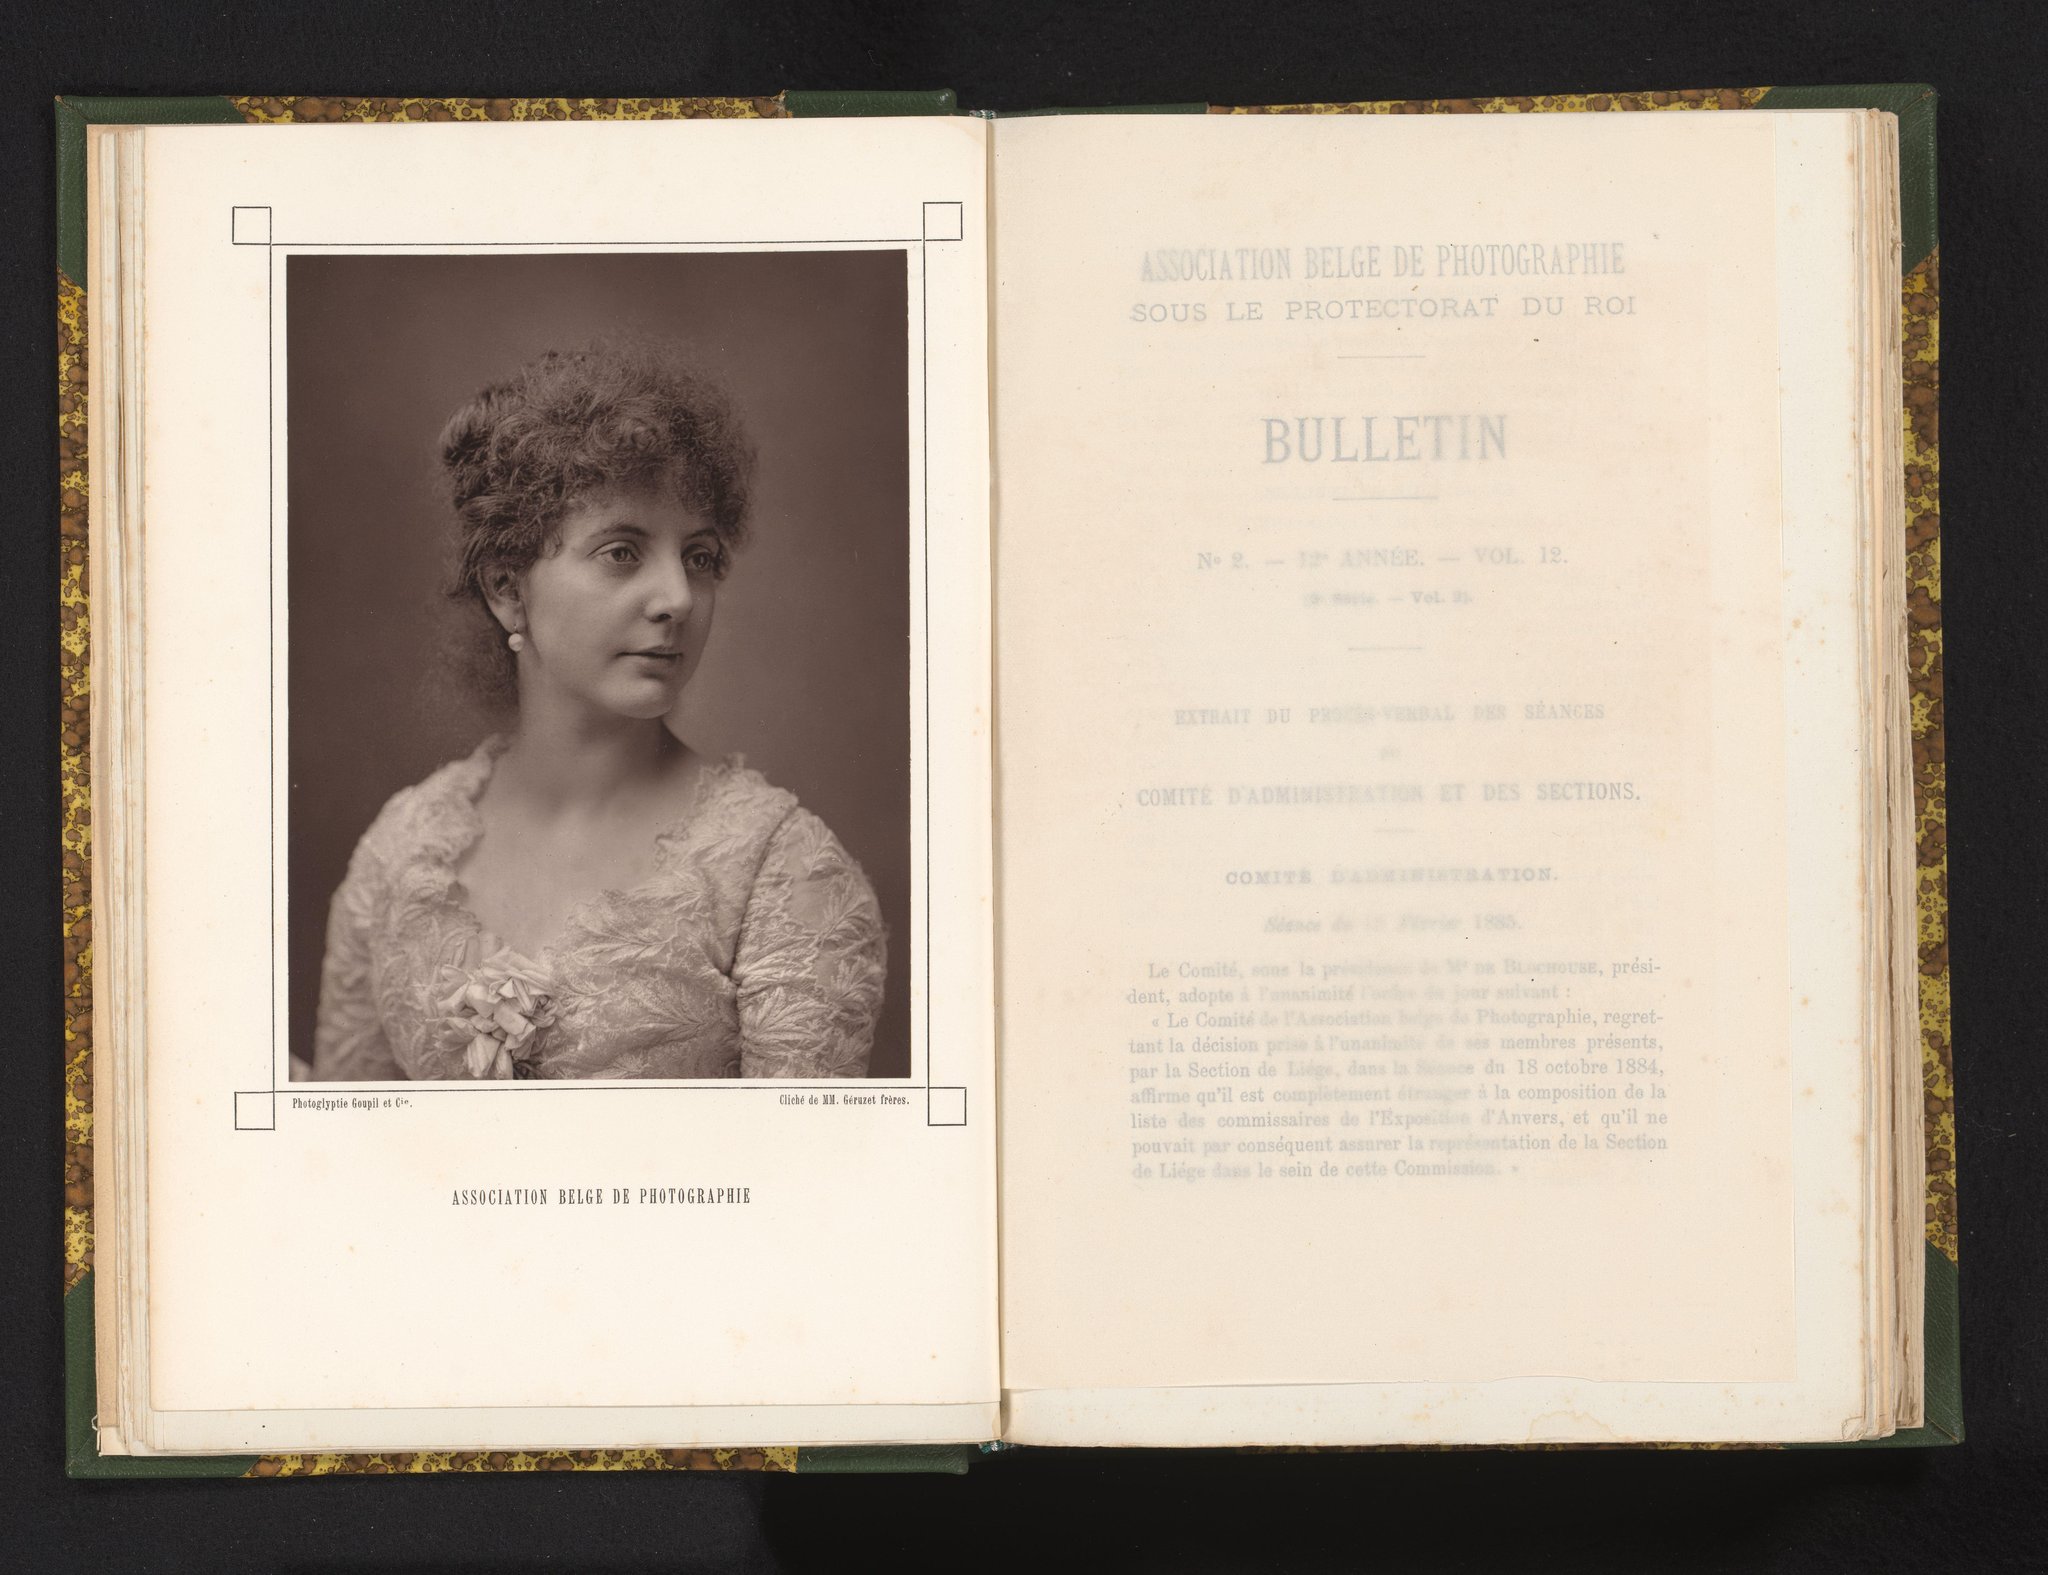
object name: page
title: Portret van een onbekende vrouw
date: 1879-1884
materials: paper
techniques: woodburytype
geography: paris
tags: adult woman, historical persons - bb - woman